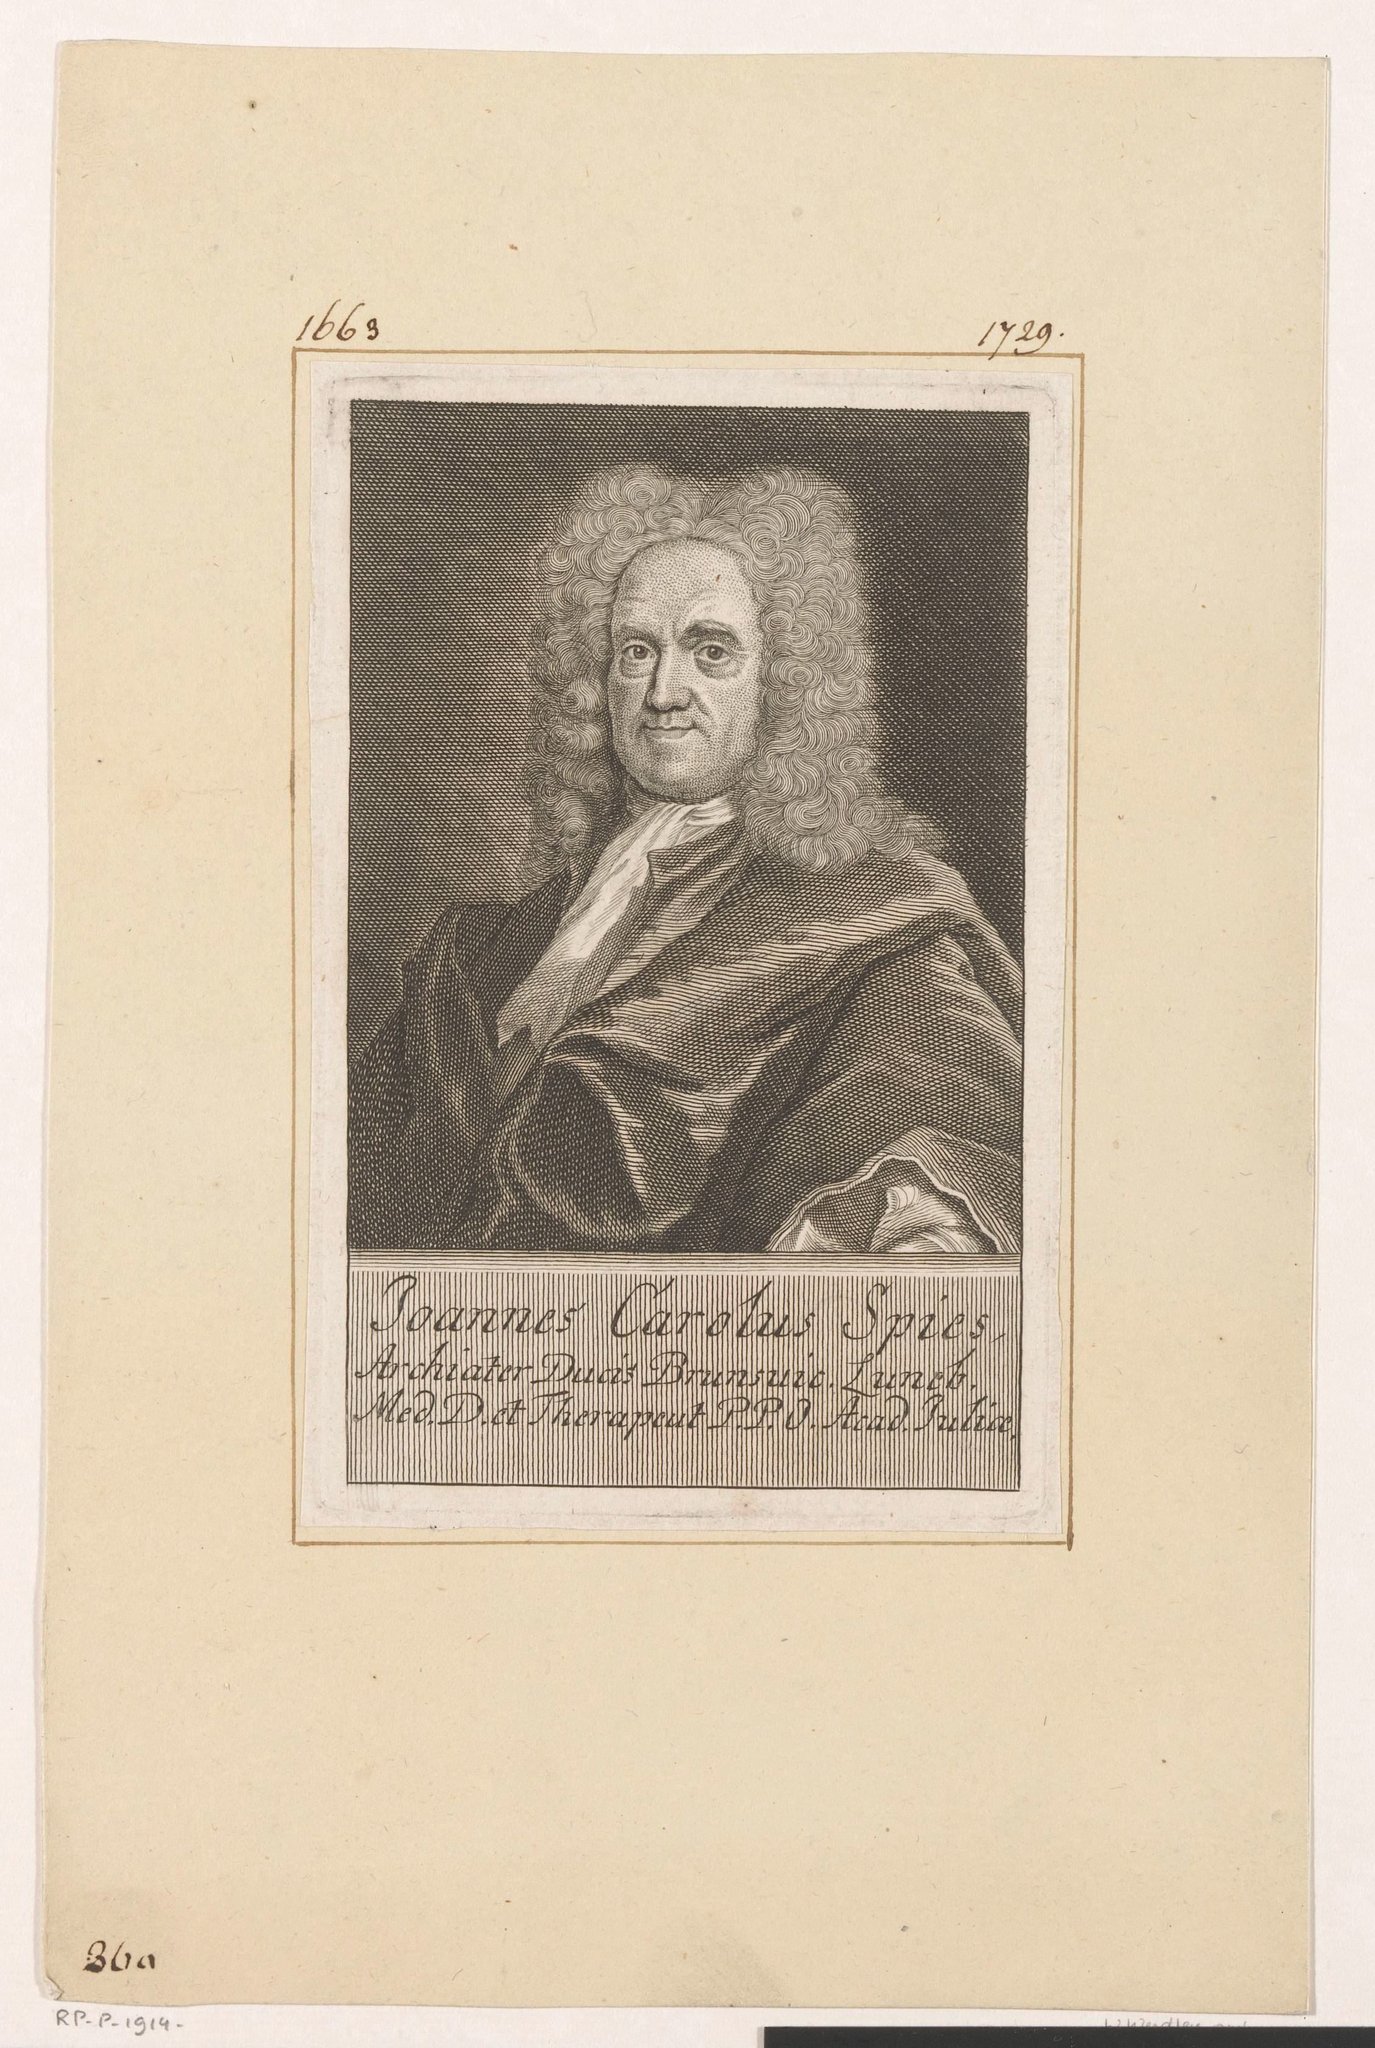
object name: print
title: Portret van Johann Carl Spies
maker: martin bernigeroth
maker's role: print maker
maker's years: 1670-1733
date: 1730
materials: paper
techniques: engraving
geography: leipzig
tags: historical persons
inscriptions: collector's mark: Lugt 2228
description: Prent ook gebruikt in: Deutsche Acta Eruditorum (...). dl. 151. Leipzig: Johann Gottlieb Gleditsch, 1730.